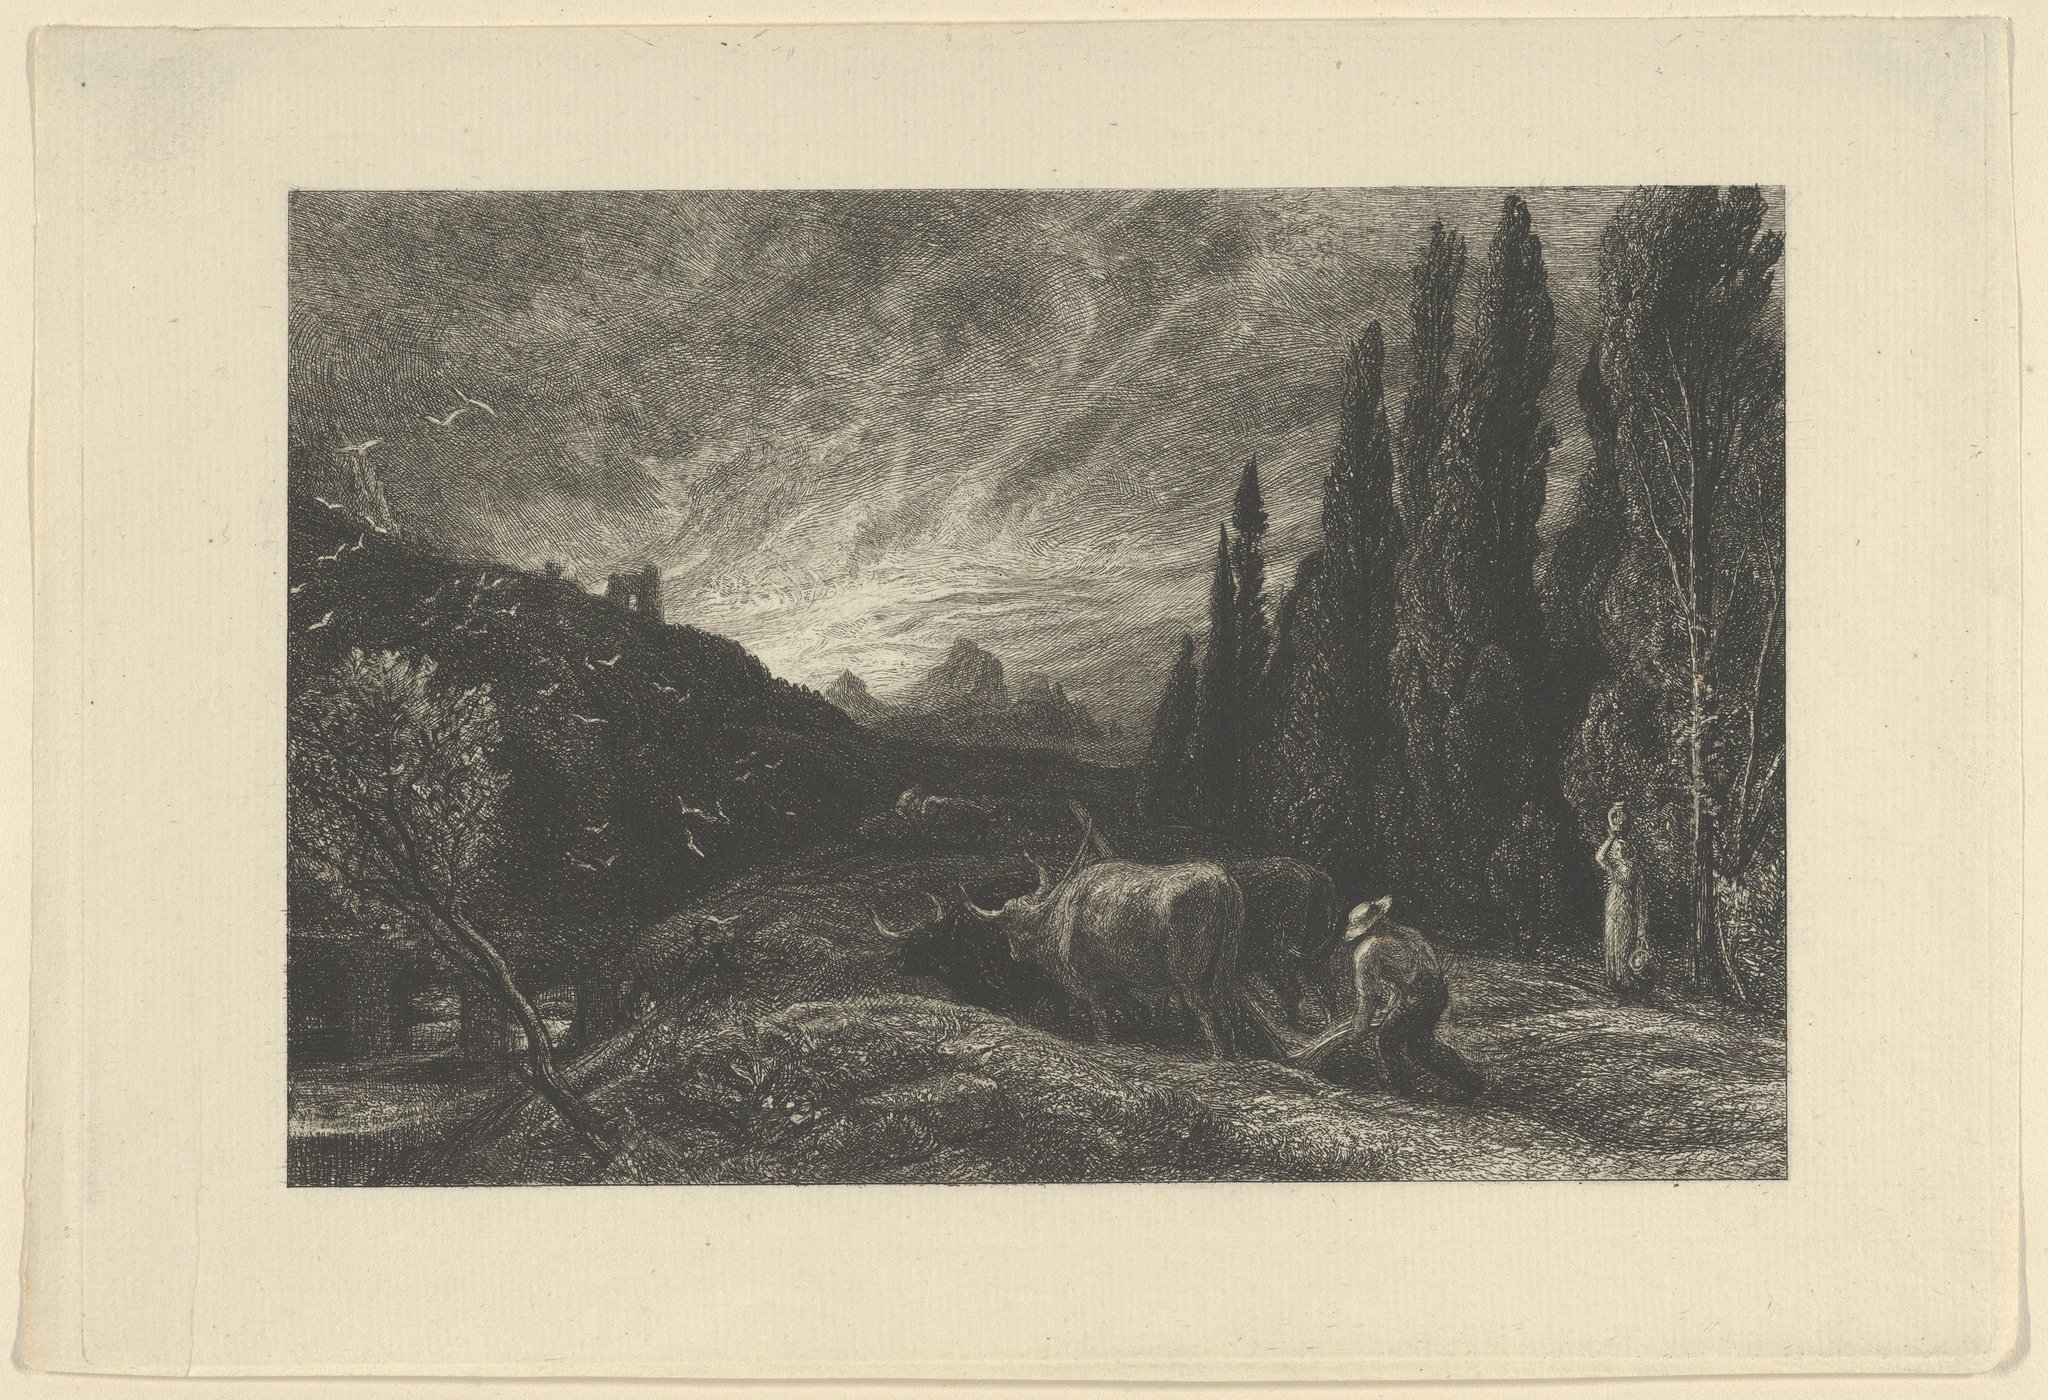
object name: print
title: The Early Ploughman, or Morning Spread Upon the Mountains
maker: samuel palmer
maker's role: artist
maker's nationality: british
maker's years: 1805-1881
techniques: etching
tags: animals,men,mountains,trees,working